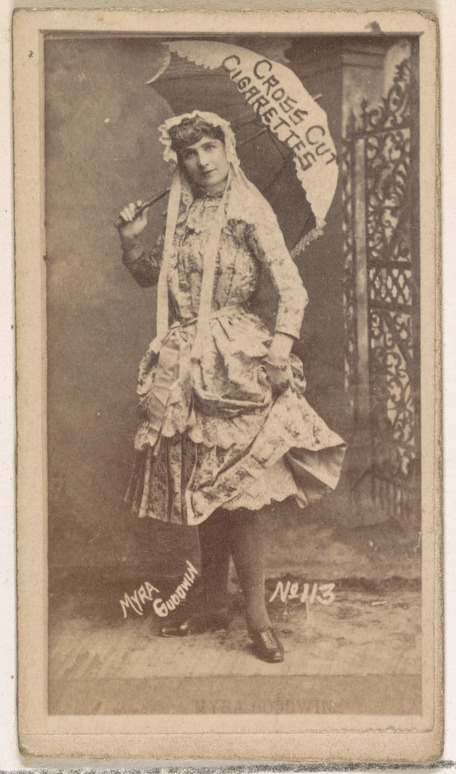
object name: print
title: Card Number 113, Myra Goodman, from the Actors and Actresses series (N145-1) issued by Duke Sons & Co. to promote Cross Cut Cigarettes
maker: w. duke, sons & co.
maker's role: publisher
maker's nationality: american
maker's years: 1870-1920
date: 1880-1889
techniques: albumen silver print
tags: portraits,women,actresses